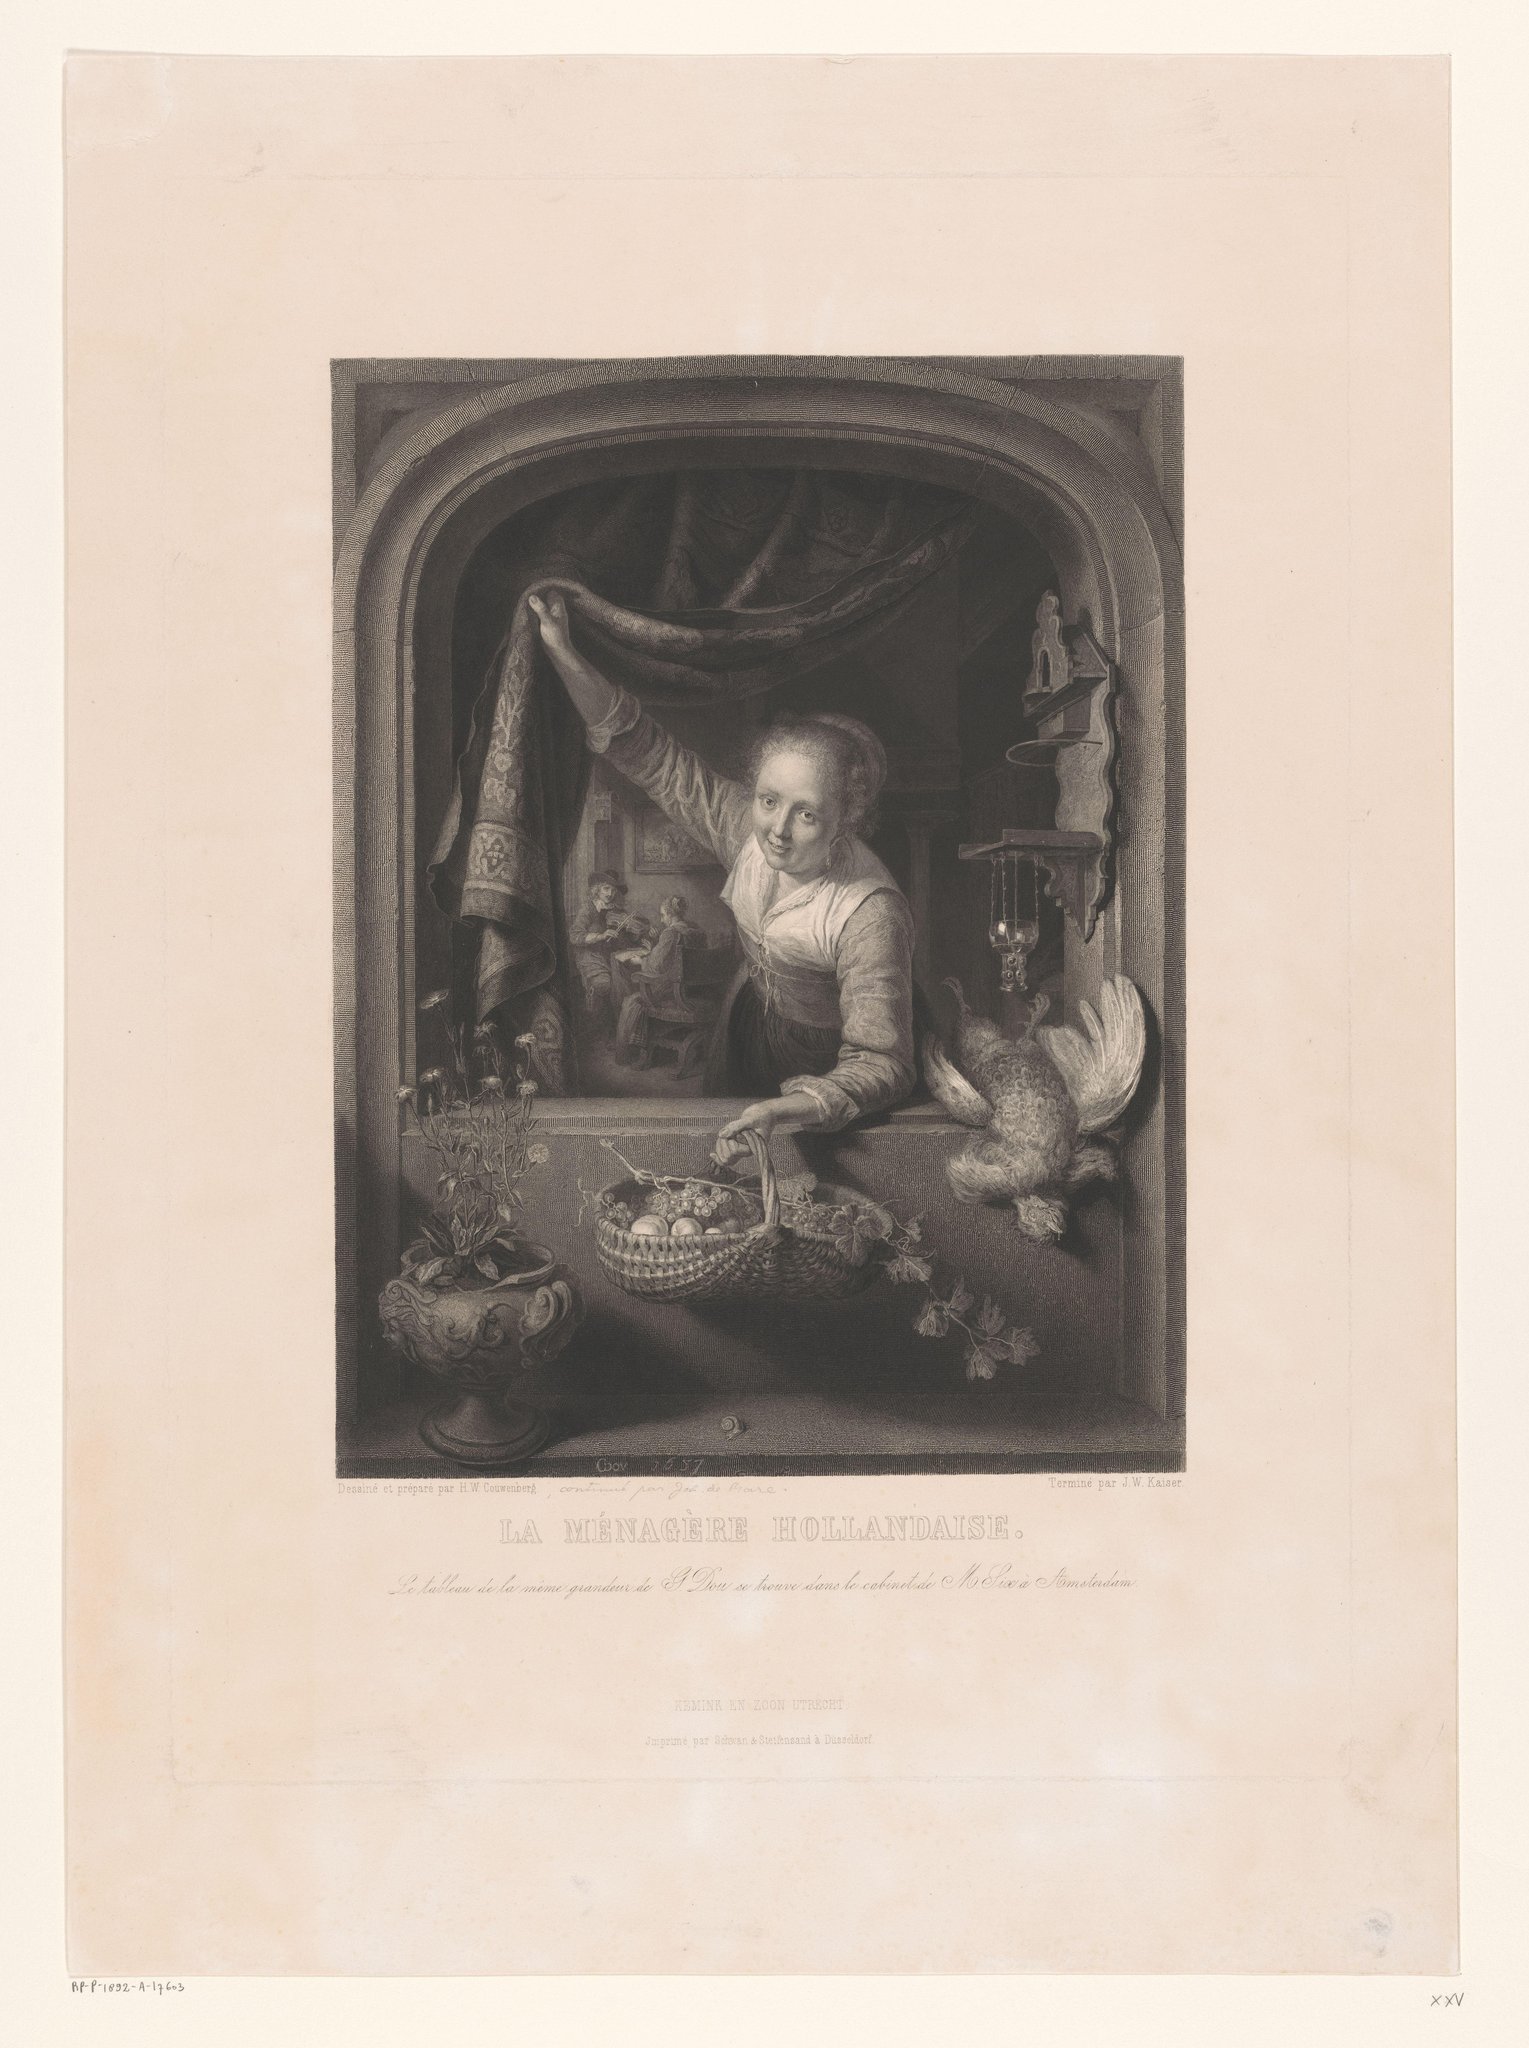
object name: print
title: La ménagerè Hollandaise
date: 1856-1890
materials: paper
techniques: engraving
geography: utrecht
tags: nesting-box, human figure at (open) window, seen from outside, attributes of aesculapius: cock, one person playing an instrument, shop-window, show-window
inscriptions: inscription: ‘[...] par Joh de Mare’, collector's mark: Lugt 2228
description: Een jonge vrouw met een mand met vruchten in de hand hangt uit een venster. Ze houdt het gordijn opzij zodat het interieur achter haar zichtbaar is. In het vertrek zijn een man en een vrouw aan het musiceren. In de vensterbank hangt een vogelhuis, ligt een dode haan en staat een vaas met bloemen.